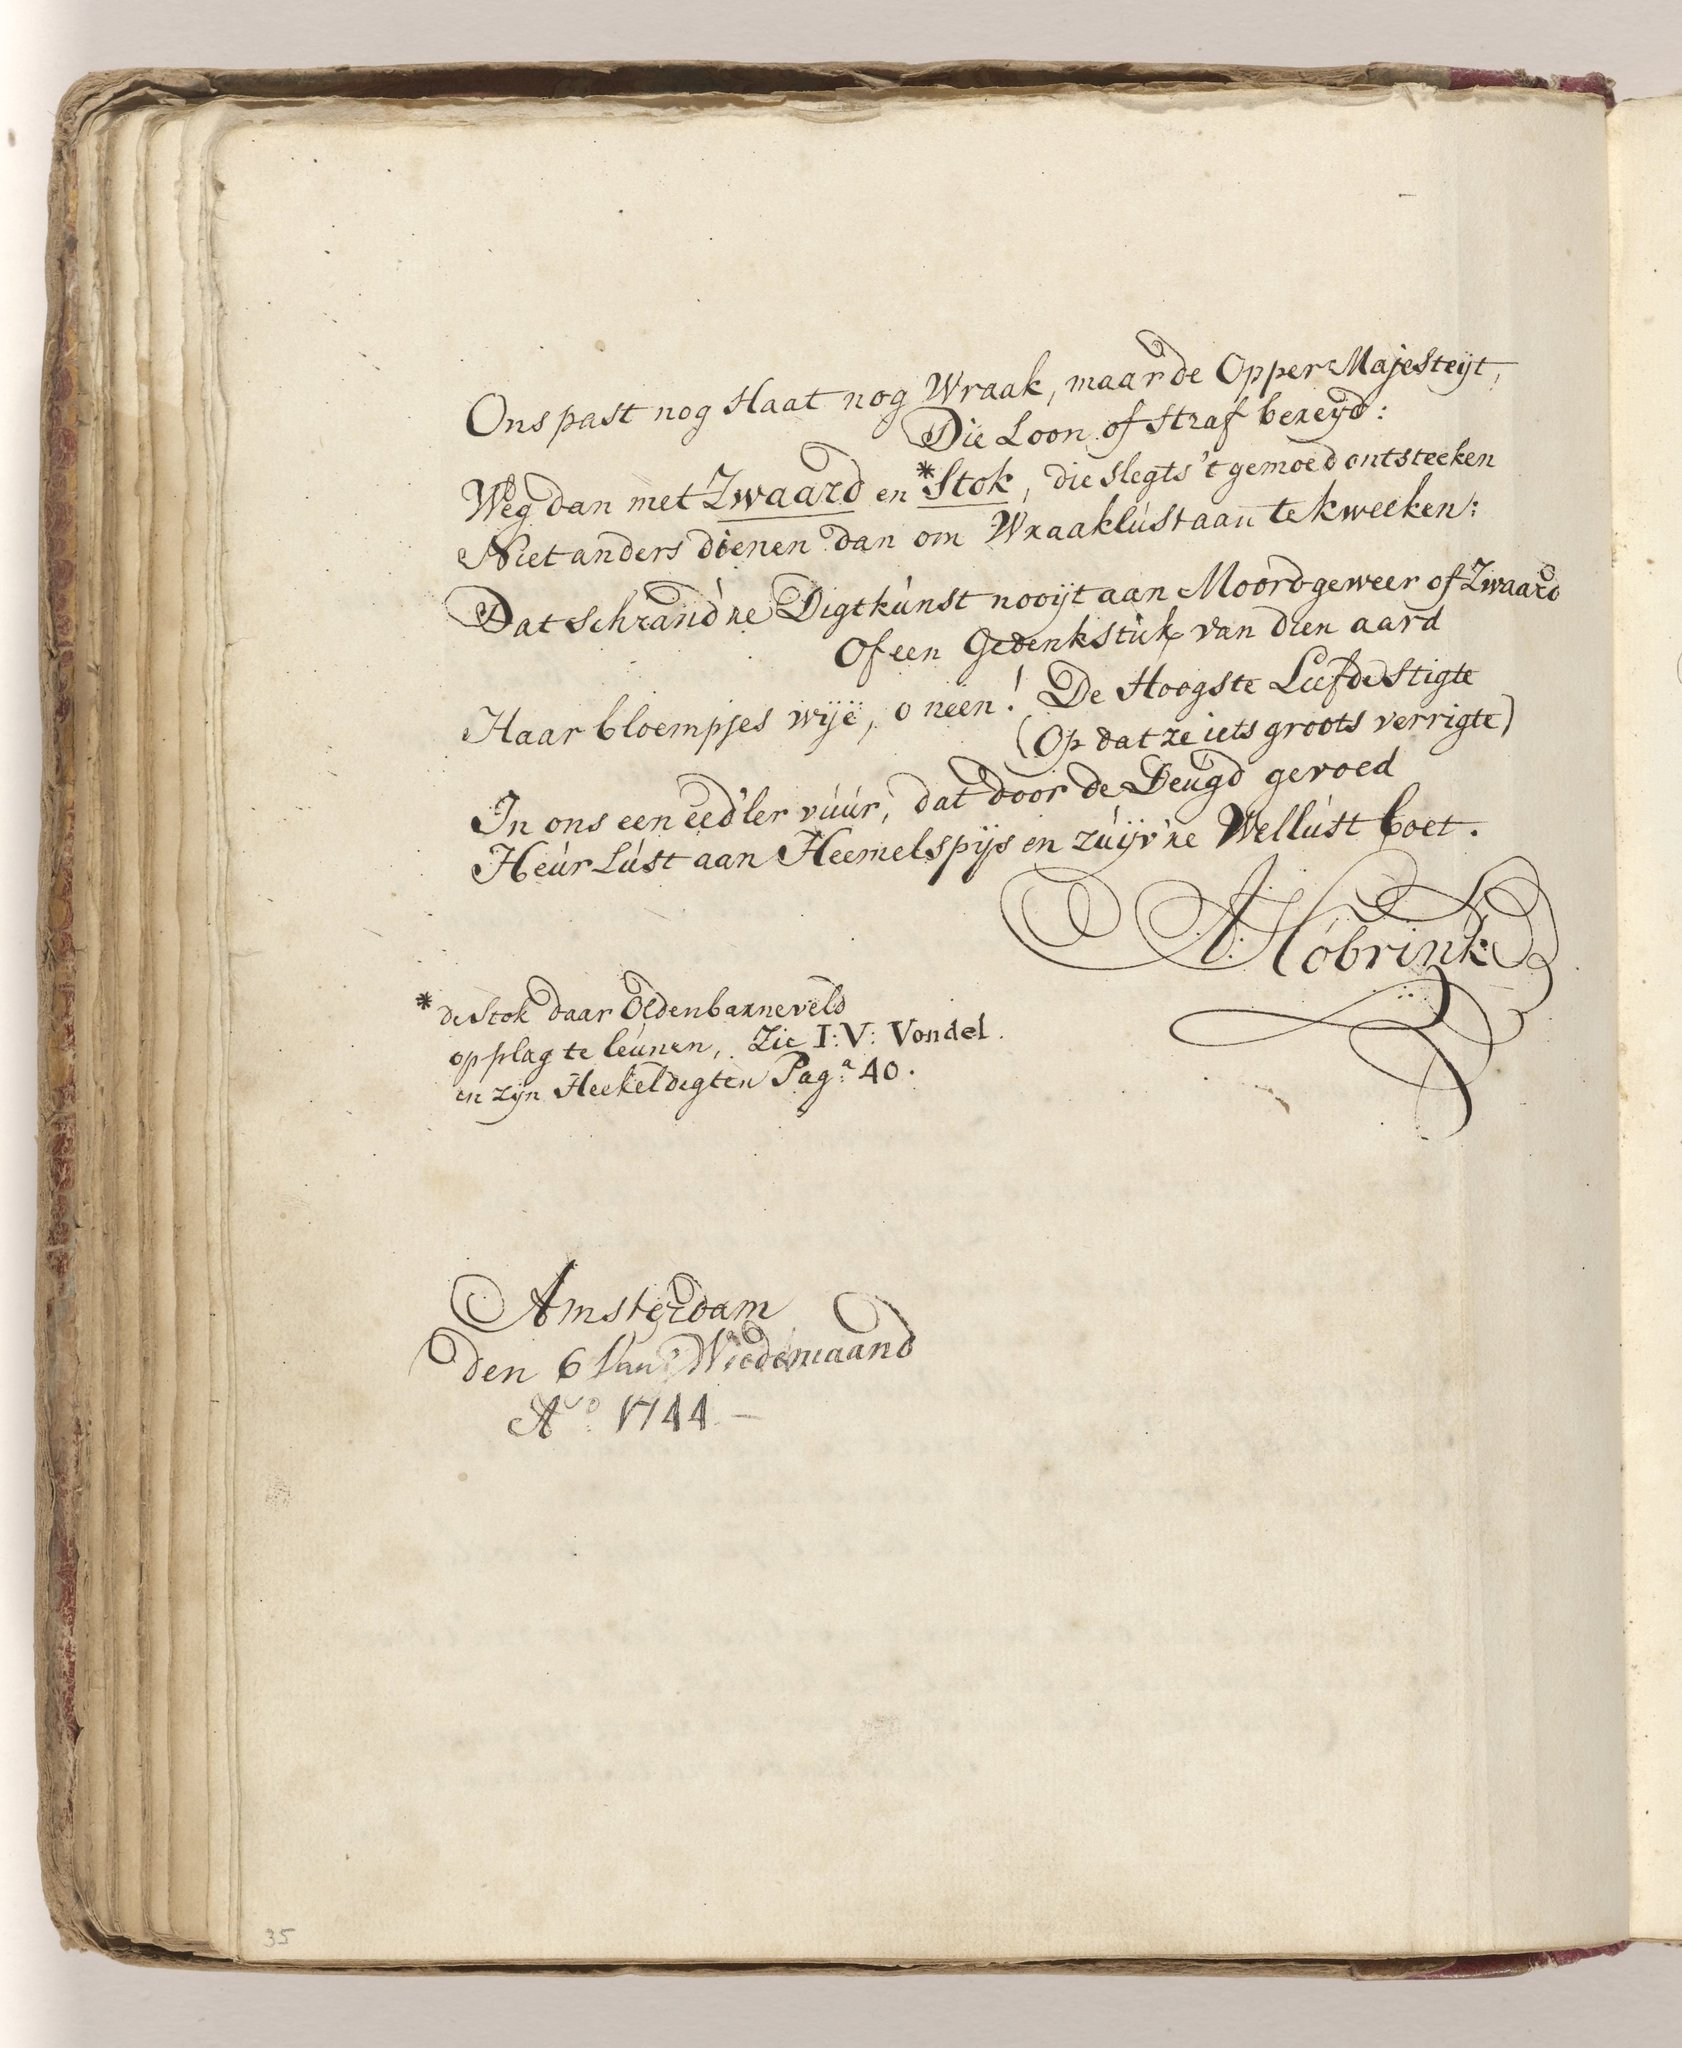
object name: manuscript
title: Gedicht op het zwaard waarmee Johan van Oldenbarnevelt in 1619 zou zijn onthoofd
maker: a. hobrink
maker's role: dichter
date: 1744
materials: ink, paper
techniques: writing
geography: amsterdam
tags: the hague, johan van oldenbarnevelt, frans greenwood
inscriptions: date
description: Vers van A. Hobrink (tweede deel). Onderdeel van het boek met gedichten uit de jaren 1743-1745 op het zwaard waarmee Johan van Oldenbarnevelt in 1619 zou zijn onthoofd. Het zwaard was eigendom van Frans Greenwood.